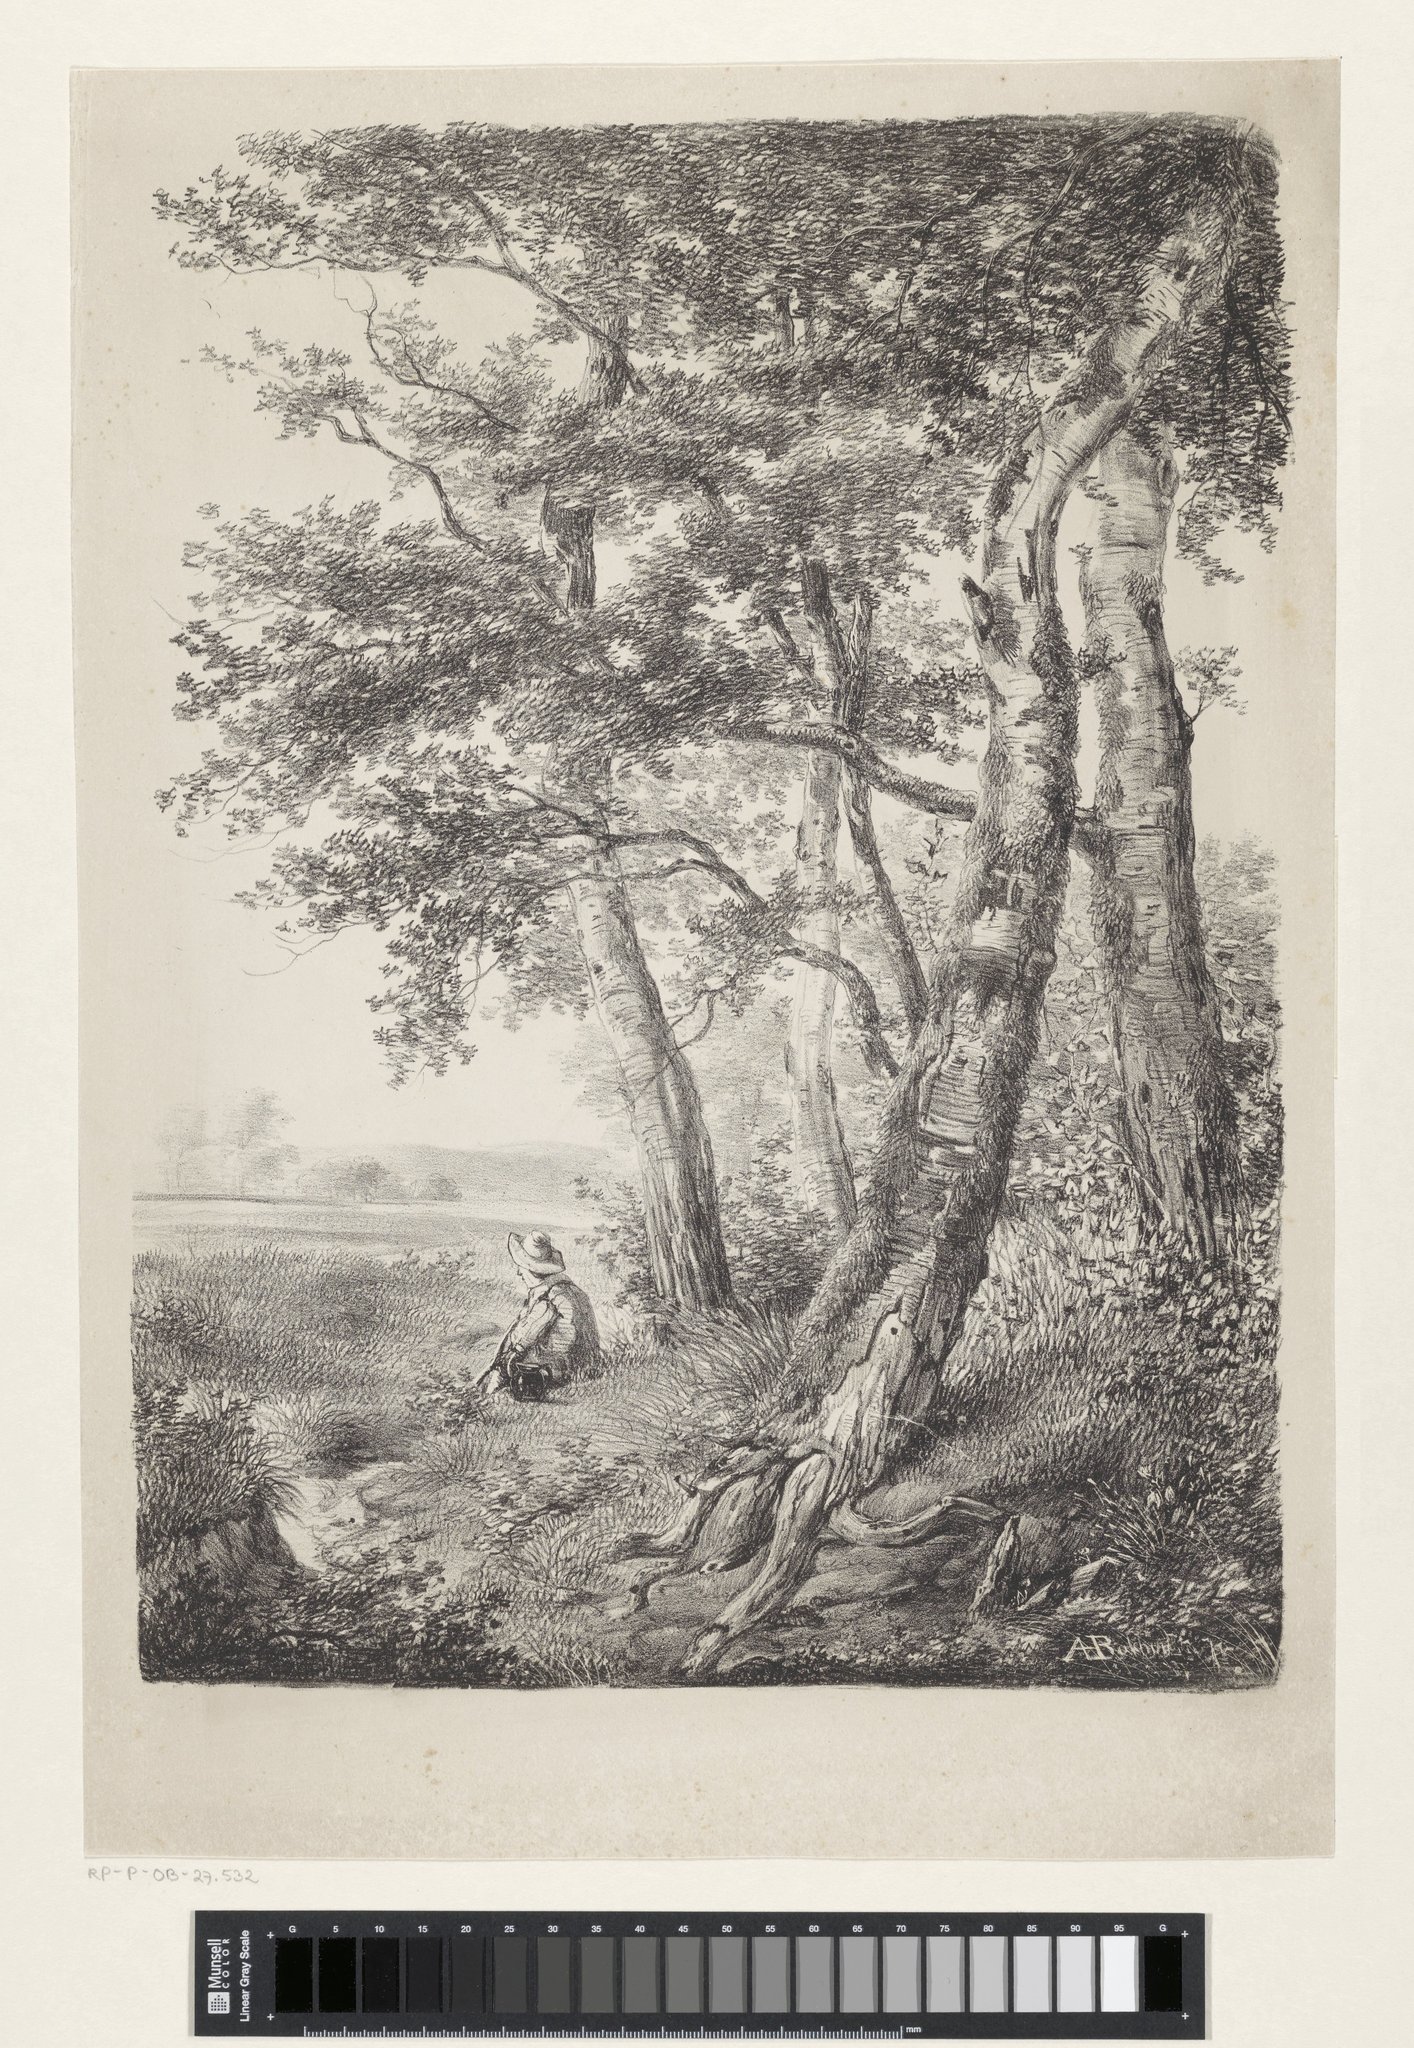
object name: print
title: Zittende figuur in landschap met bomen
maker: alexander hieronymus bakhuyzen (ii)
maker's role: print maker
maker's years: 1826-1878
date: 1836-1878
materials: paper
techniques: lithography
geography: netherlands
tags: meadow, pasture, groups of trees, trees: birch, sitting on the ground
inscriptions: collector's mark: Lugt 2228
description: Een figuur zit onder een groep bomen en kijkt uit over een weiland. Naast hem staat een kruik.